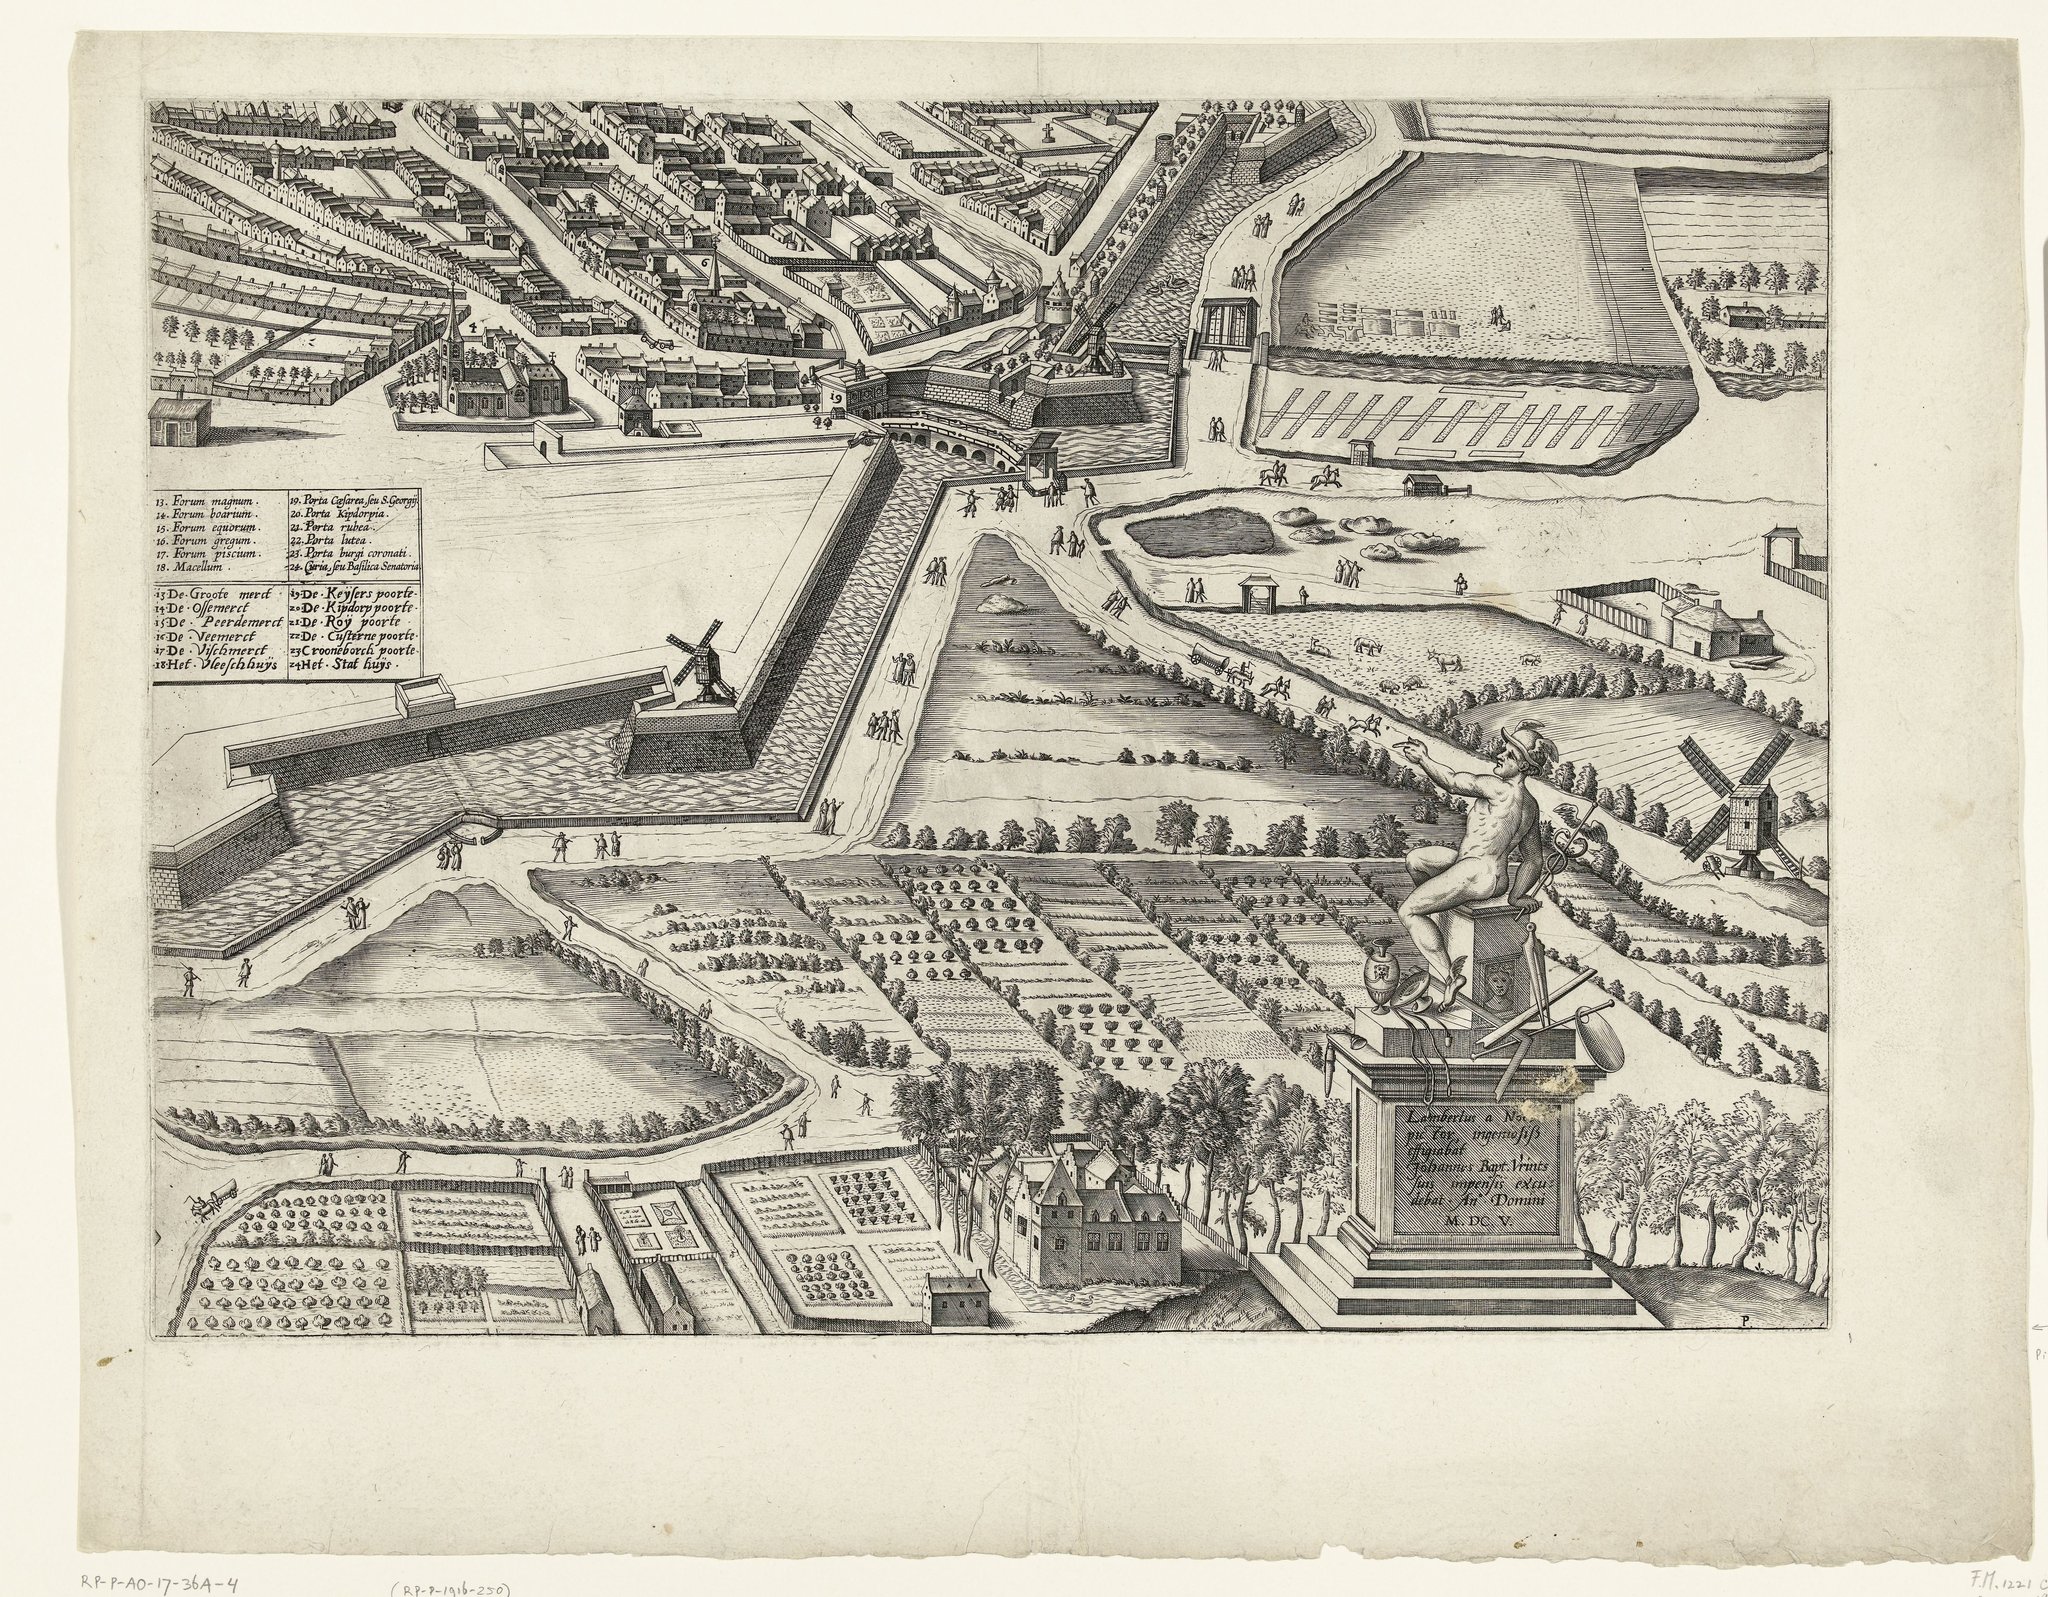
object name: print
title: Assiegement de la ville d'Anvers, attenté par le conte Maurice de Nassau et les rebels de leurs Ser.mes Altezes, le 17. de may, l'an 1605. Sans effect, et avecq perte de beaucoup de gens et navires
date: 1569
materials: paper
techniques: engraving, etching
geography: southern netherlands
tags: ernst casimir graaf van nassau-dietz, specific aspects, allegorical aspects of mercury; mercury as patron, maps of cities, antwerp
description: Grote kaart van Antwerpen in vogelvlucht met de mislukte aanval door het Staatse leger op Antwerpen, 17 mei 1605. Gezicht op een deel van de stad en landgoeden buiten de stad. Rechtsonder Mercurius op een voetstuk met de namen van de inventor en uitgever en datering. Bovenaan links een deel van de legenda in het Latijn en Nederlands. Geheel bestaande uit vier bladen: blad rechtsonder.